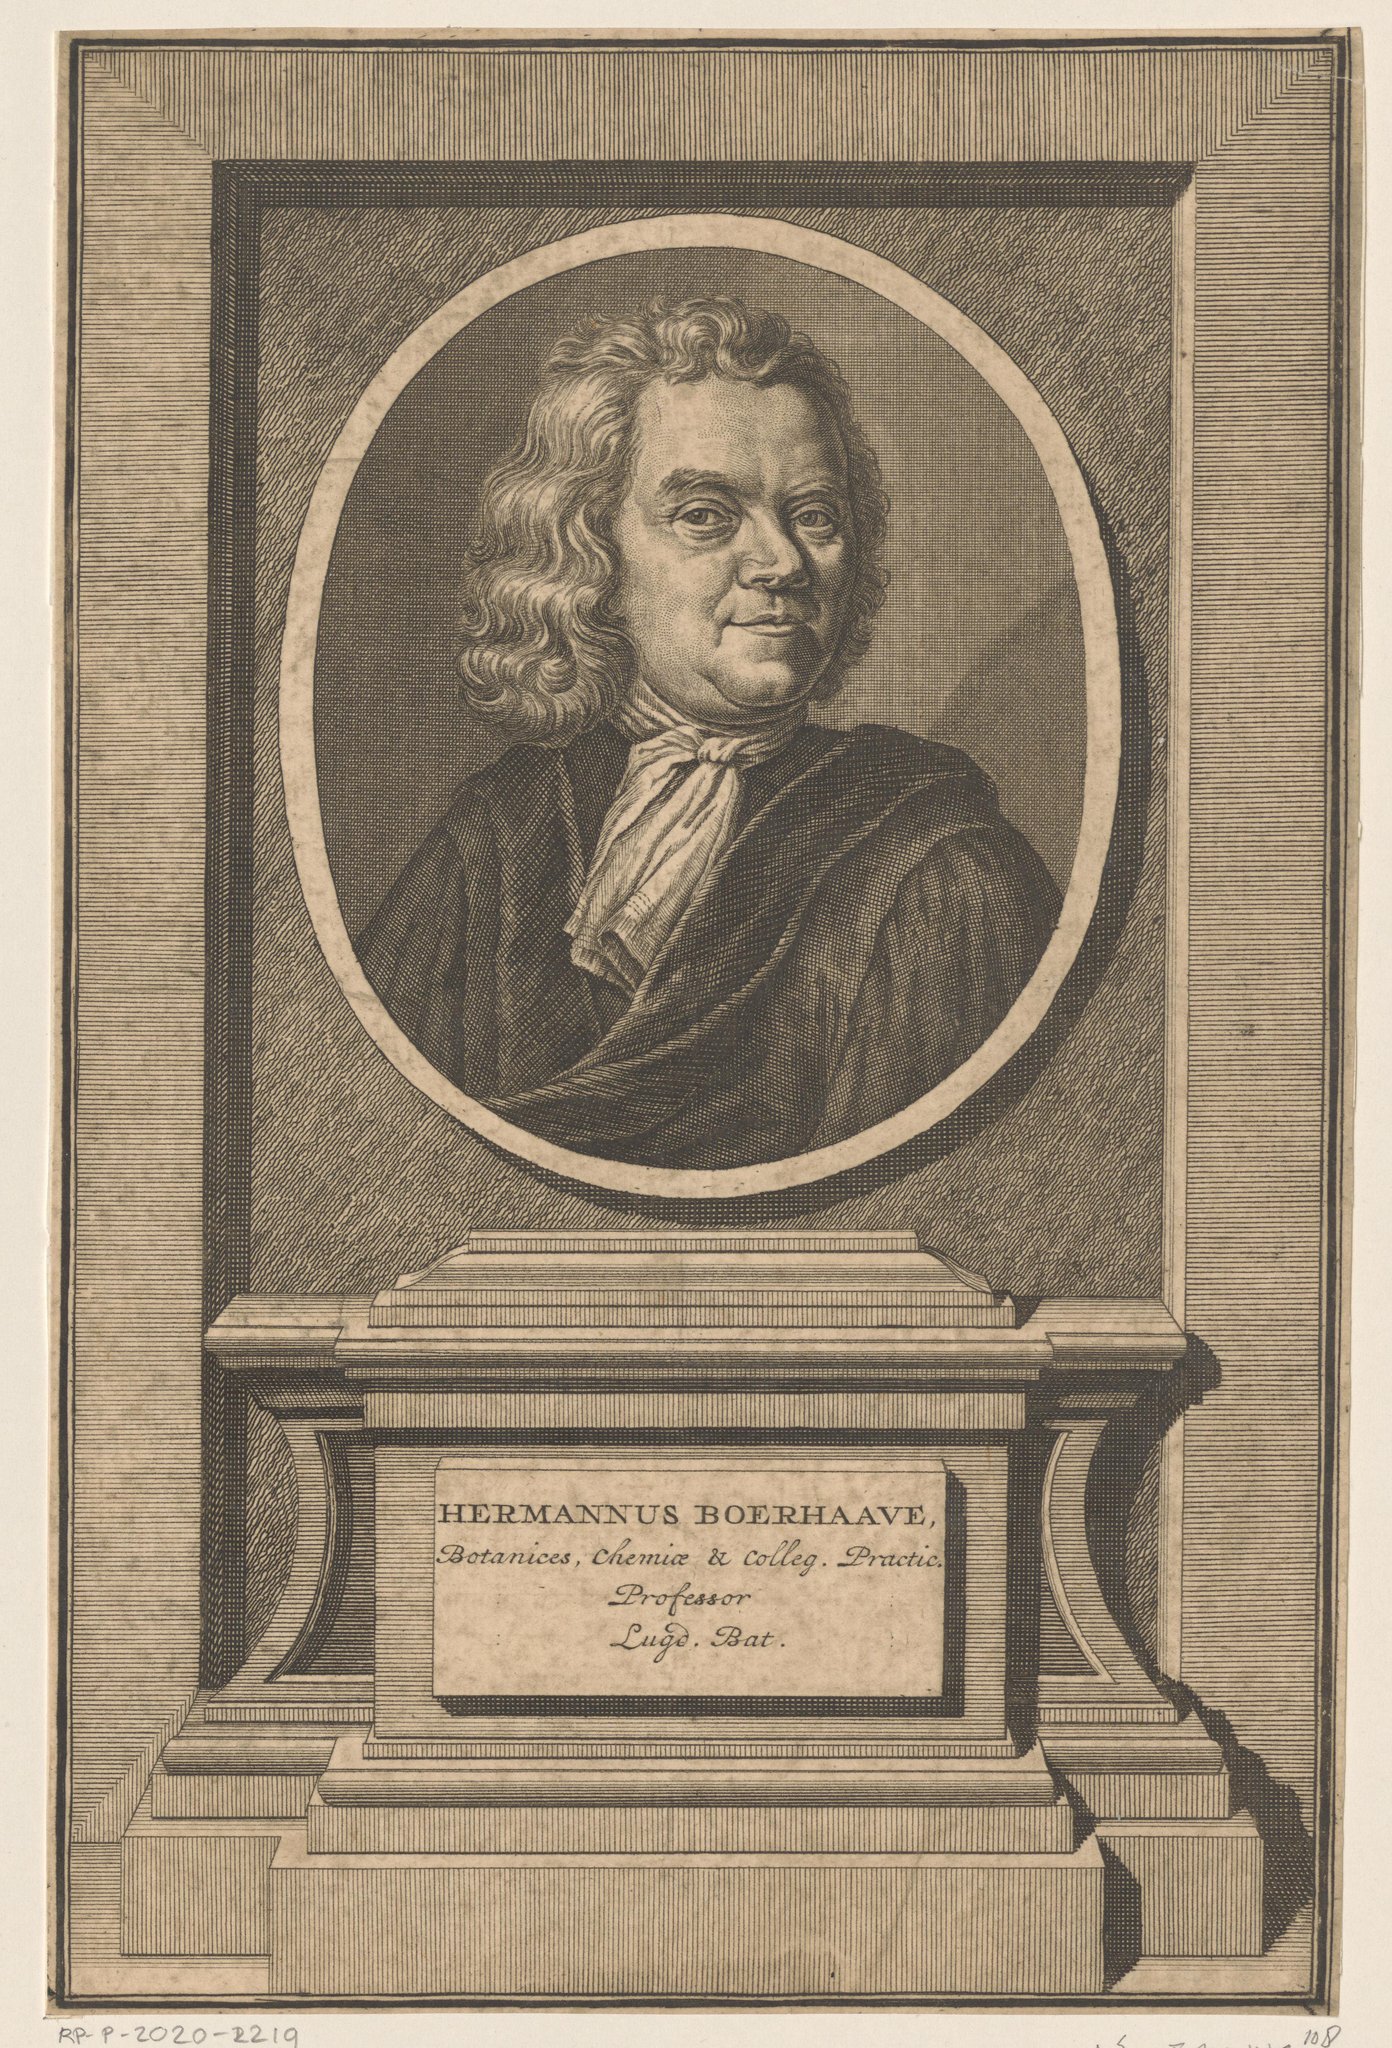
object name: book illustration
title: Portret van Hermanus Boerhaave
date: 1716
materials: paper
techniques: engraving, etching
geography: leiden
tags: leiden, hermanus boerhaave, historical persons, physician, doctor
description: Prent uit: Fundatoris, curatorum et professorum celeberrimorum, aliorumque illustrium virorum, quorum gratia, favore cura, doctrinaque academia Lugduno-Batava (...). Leiden: Pieter van der Aa, [ca. 1716].